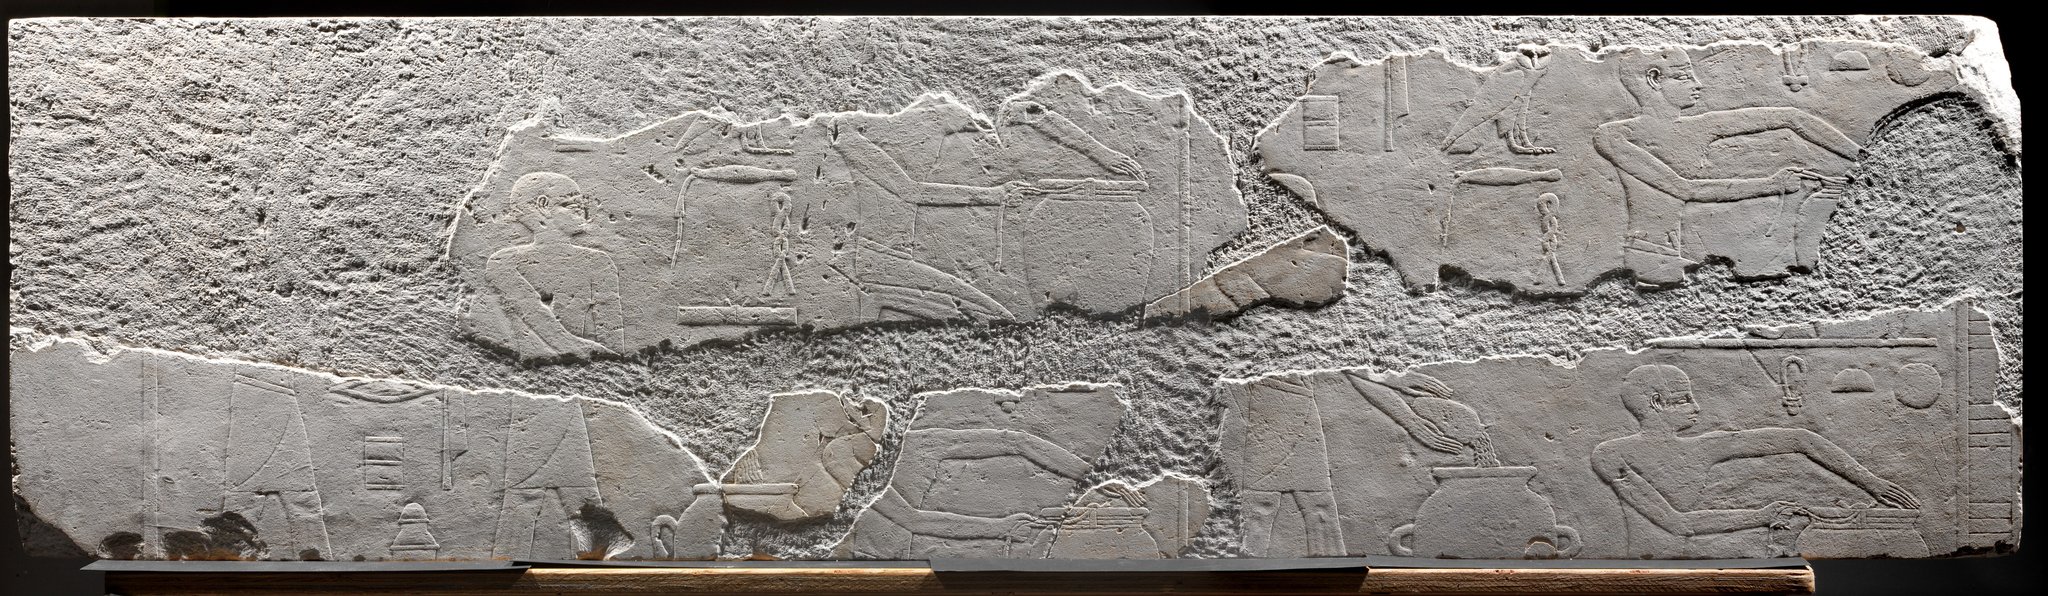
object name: relief, filling wine in jar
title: Relief, filling jars with wine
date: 1981-1950 BCE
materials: limestone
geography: egypt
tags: men,working